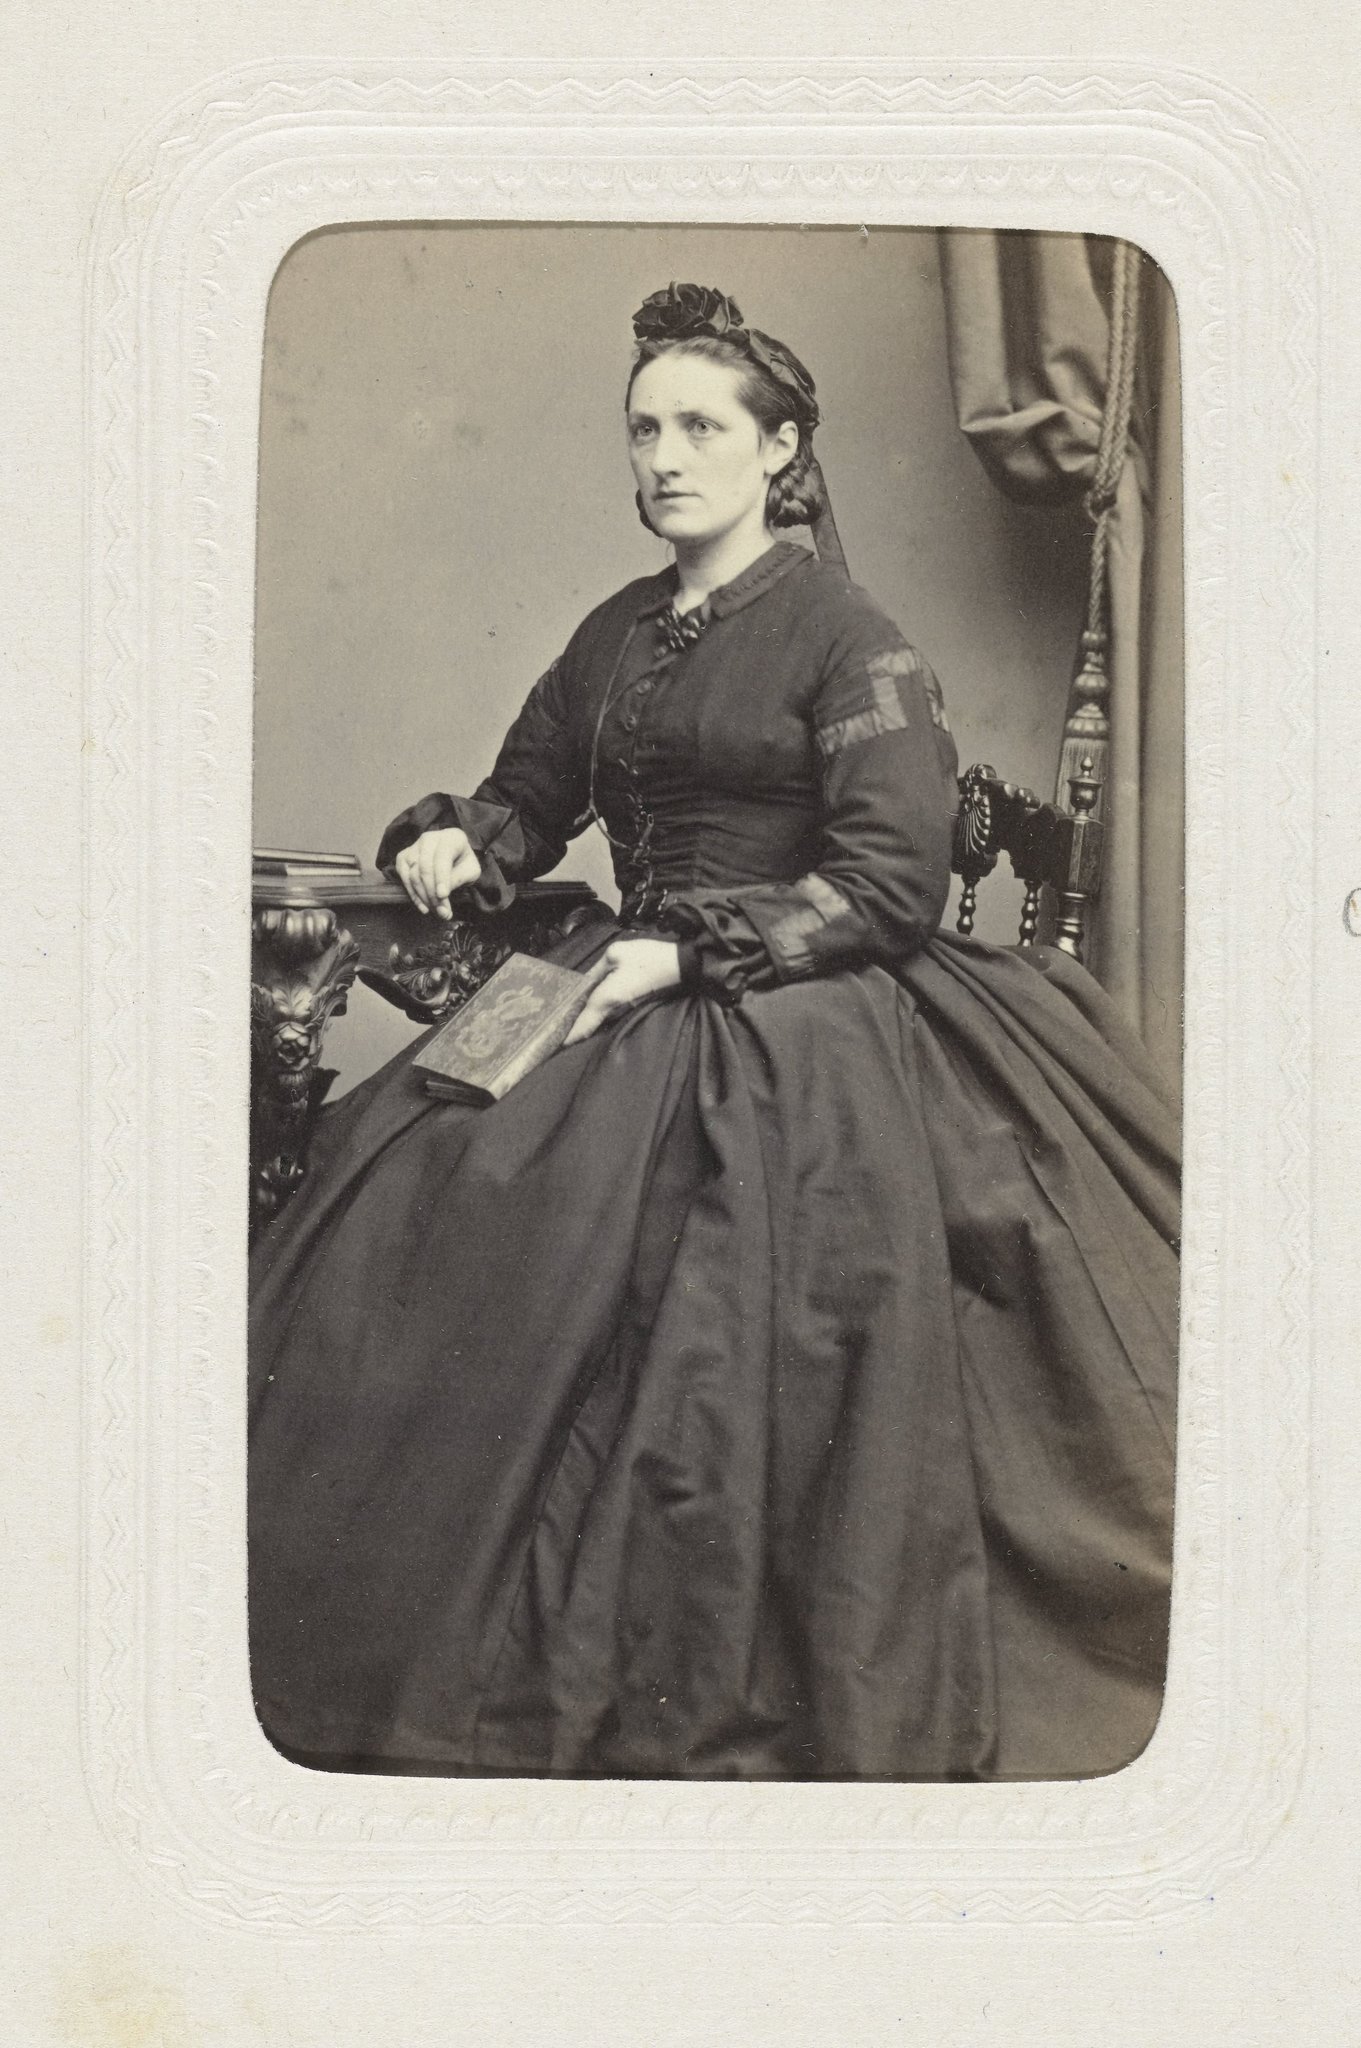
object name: carte de visite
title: Studioportret van een vrouw op een stoel in een lange zwarte jurk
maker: carl rensing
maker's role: fotograaf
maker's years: 1826-1898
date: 1863-1866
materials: cardboard, paper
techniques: albumen print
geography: amsterdam